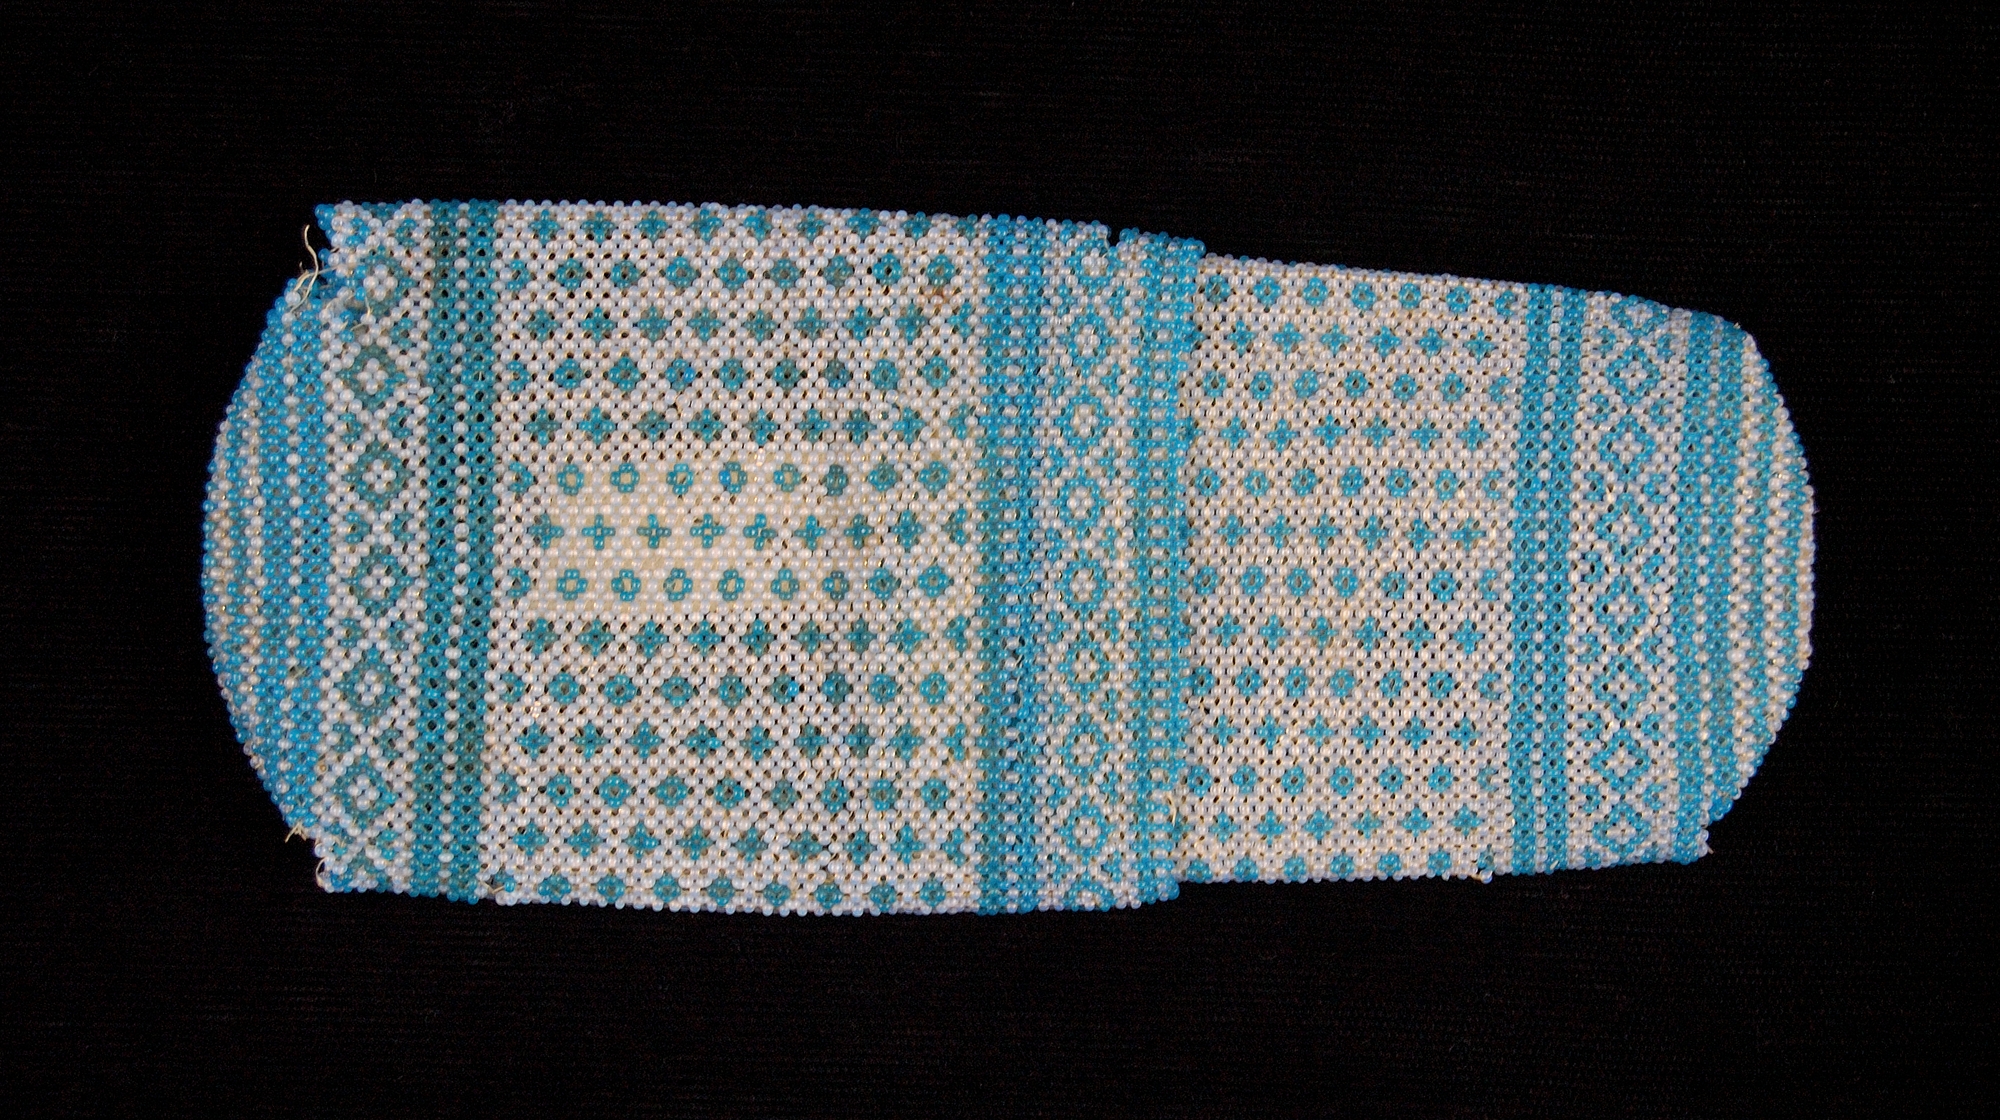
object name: purse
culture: mexican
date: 1867-1900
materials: glass